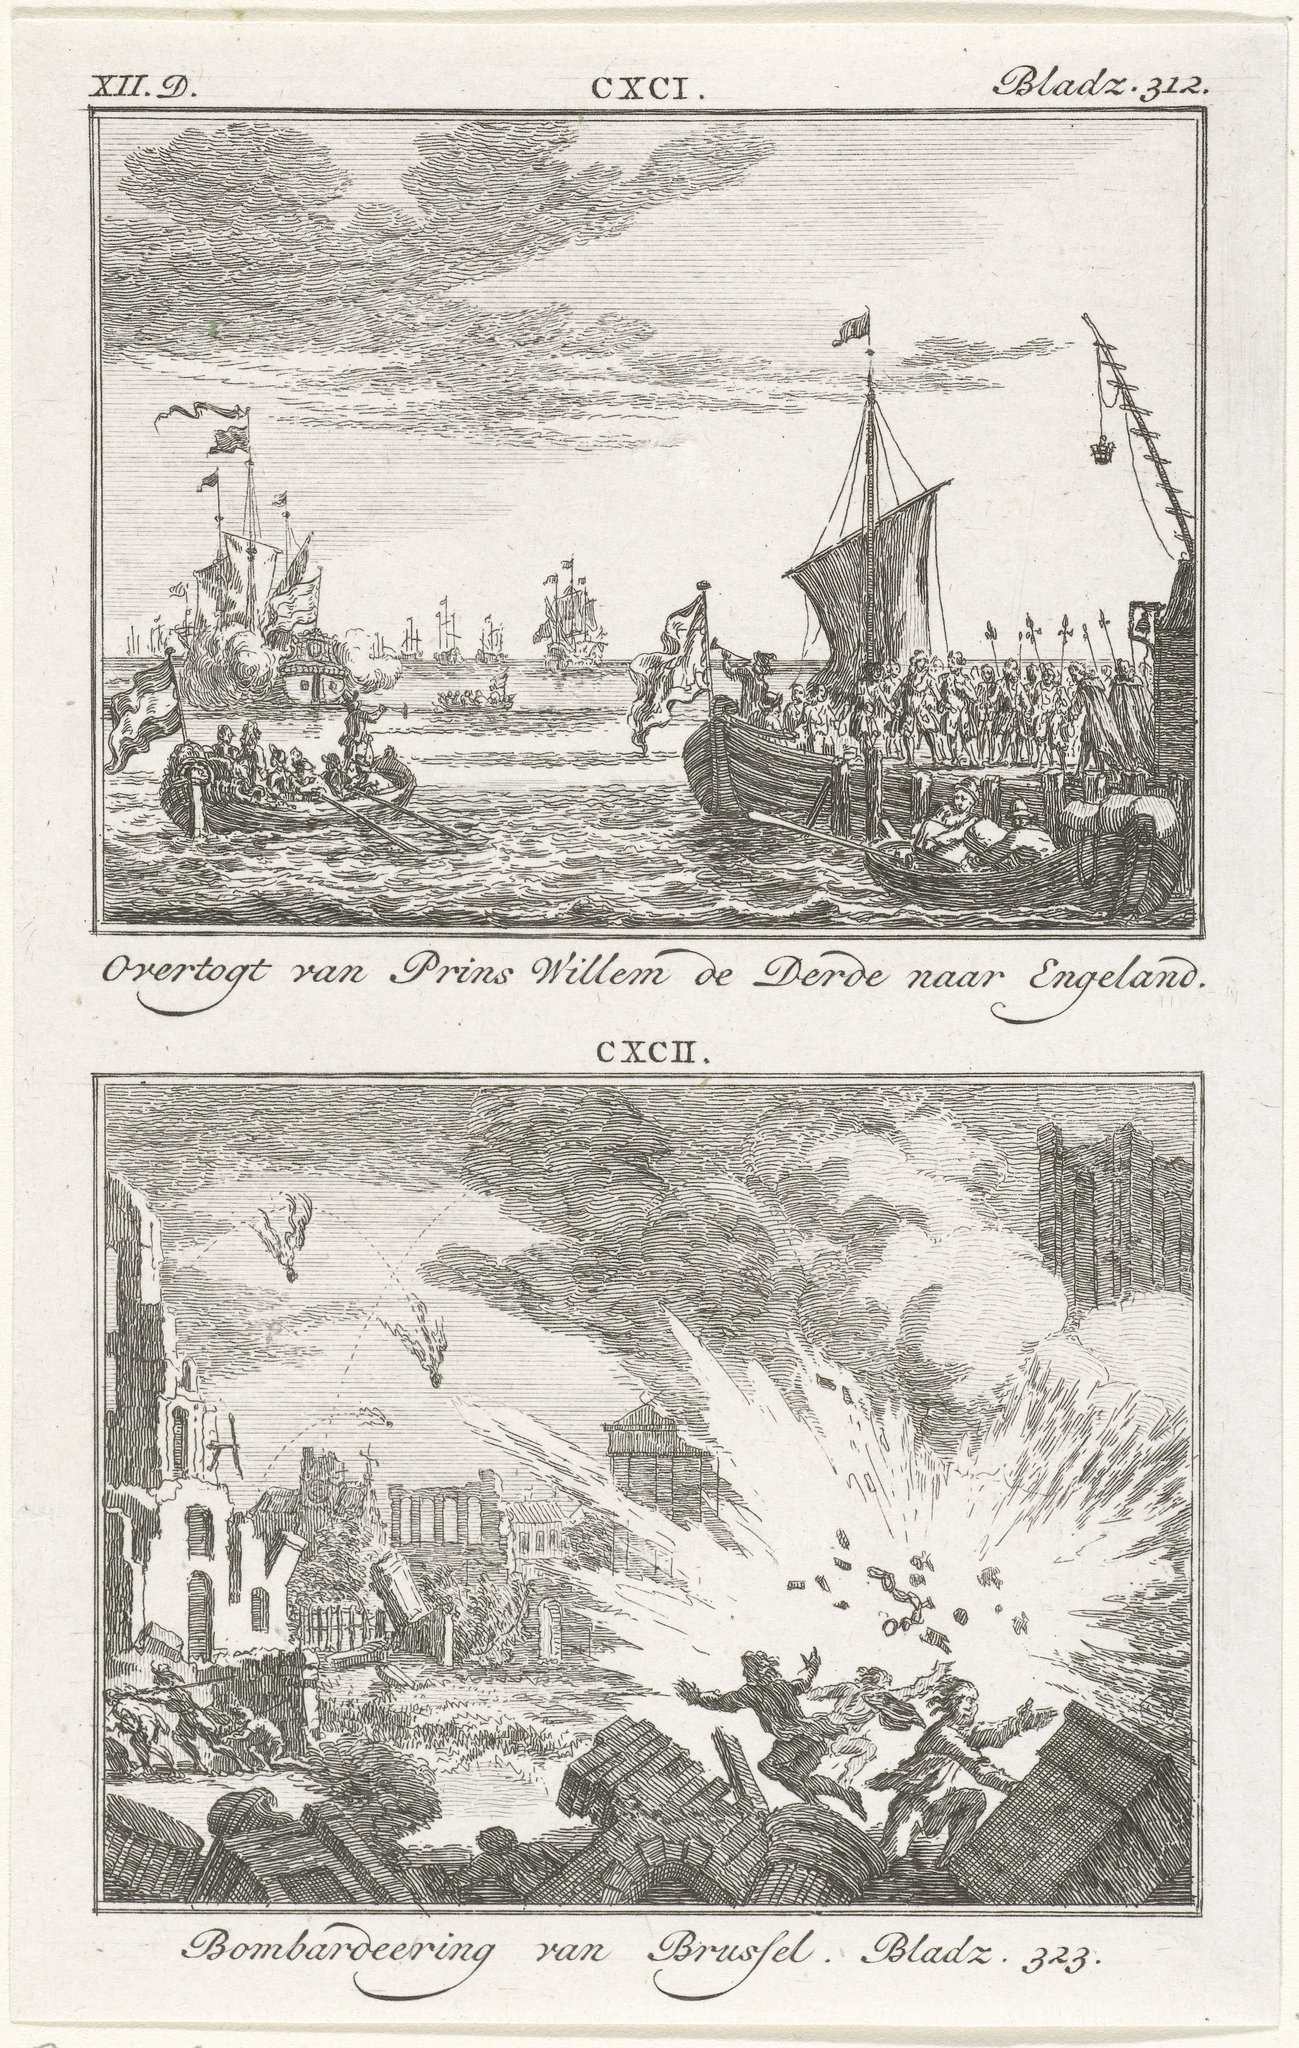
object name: book illustration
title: Overtocht van Willem III naar Engeland, 1688, en bombardement van Brussel door de Fransen, 1695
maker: simon fokke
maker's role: draughtsman, print maker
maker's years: 1712-1784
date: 1722-1784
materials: paper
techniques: etching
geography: amsterdam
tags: troop movements, transportation, bombardment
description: Voorstellingen uit de vaderlandse geschiedenis. Boven: Zicht op water met diverse schepen, rechts stapt Willem III onder begeleiding aan boord van zijn schip. Onder: Stad tijdens bombardement, op de voorgrond drie figuren voor een explosie. Twee voorstellingen van één plaat, respectievelijk genummerd: CXCI en CXCII. Het blad is linksboven gemerkt: XII.D.